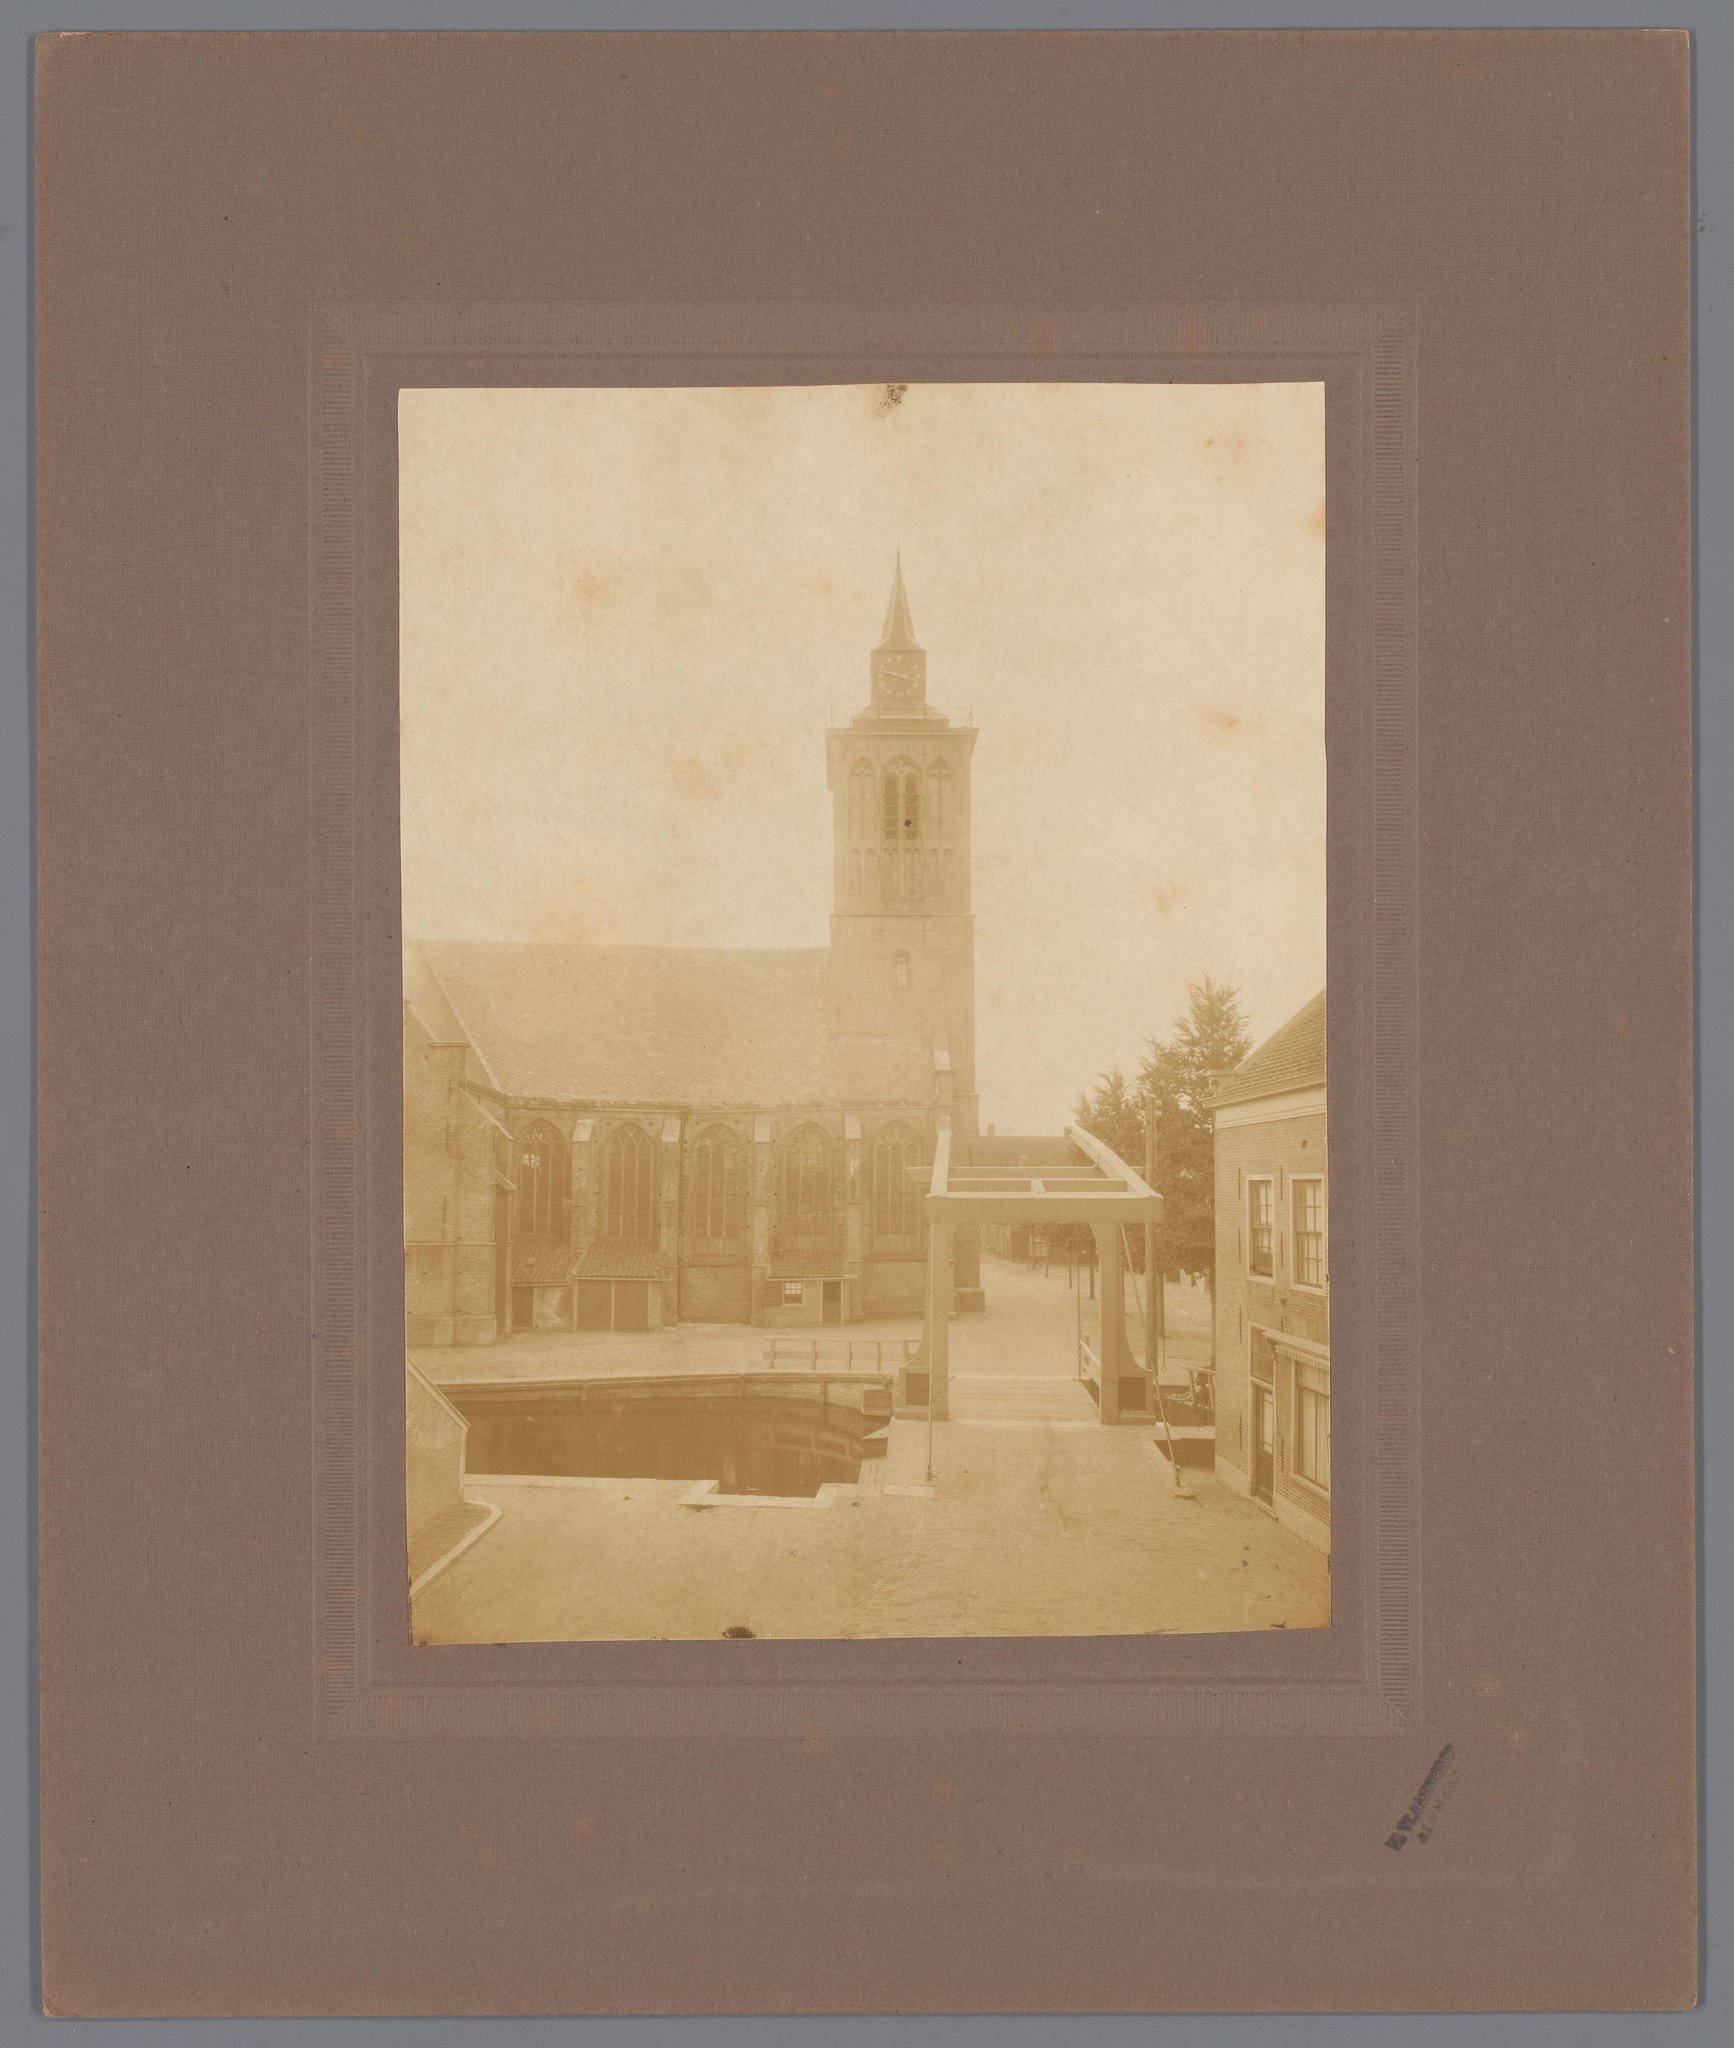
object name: photograph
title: Aanzicht op toren en schip van Nederlands Hervormde Kerk in De Rijp, Noord-Holland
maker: leonard vlaanderen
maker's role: fotograaf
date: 1921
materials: cardboard, photographic support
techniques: gelatin silver print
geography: alkmaar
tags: de rijp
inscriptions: date, annotation: ‘De Rijp 1921’, stamp: ‘L. VLAANDEREN//ALKMAAR’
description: Aanzicht op toren en schip van Nederlands Hervormde Kerk in De Rijp, Noord-Holland.